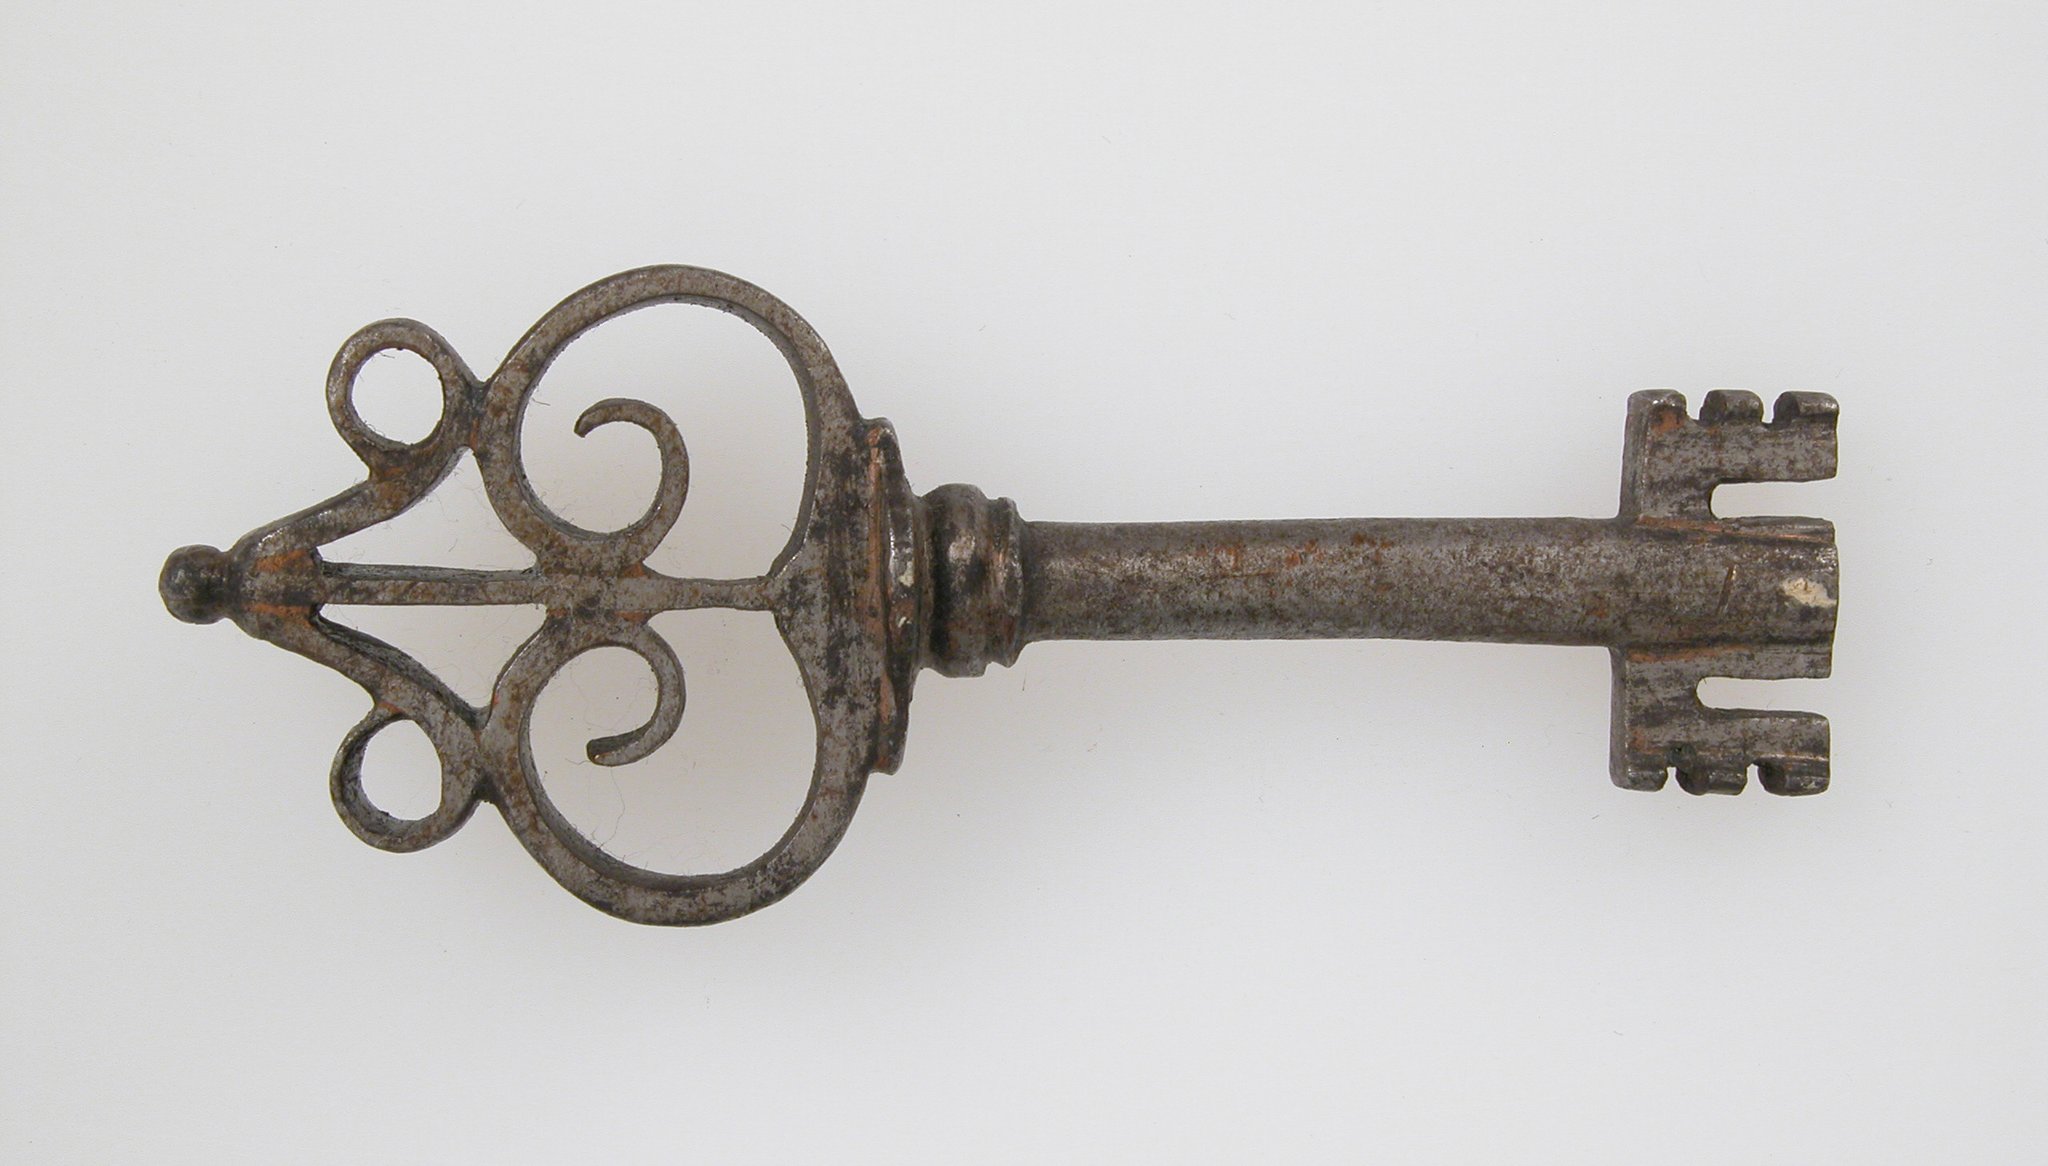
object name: key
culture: german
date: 1401-1500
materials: iron